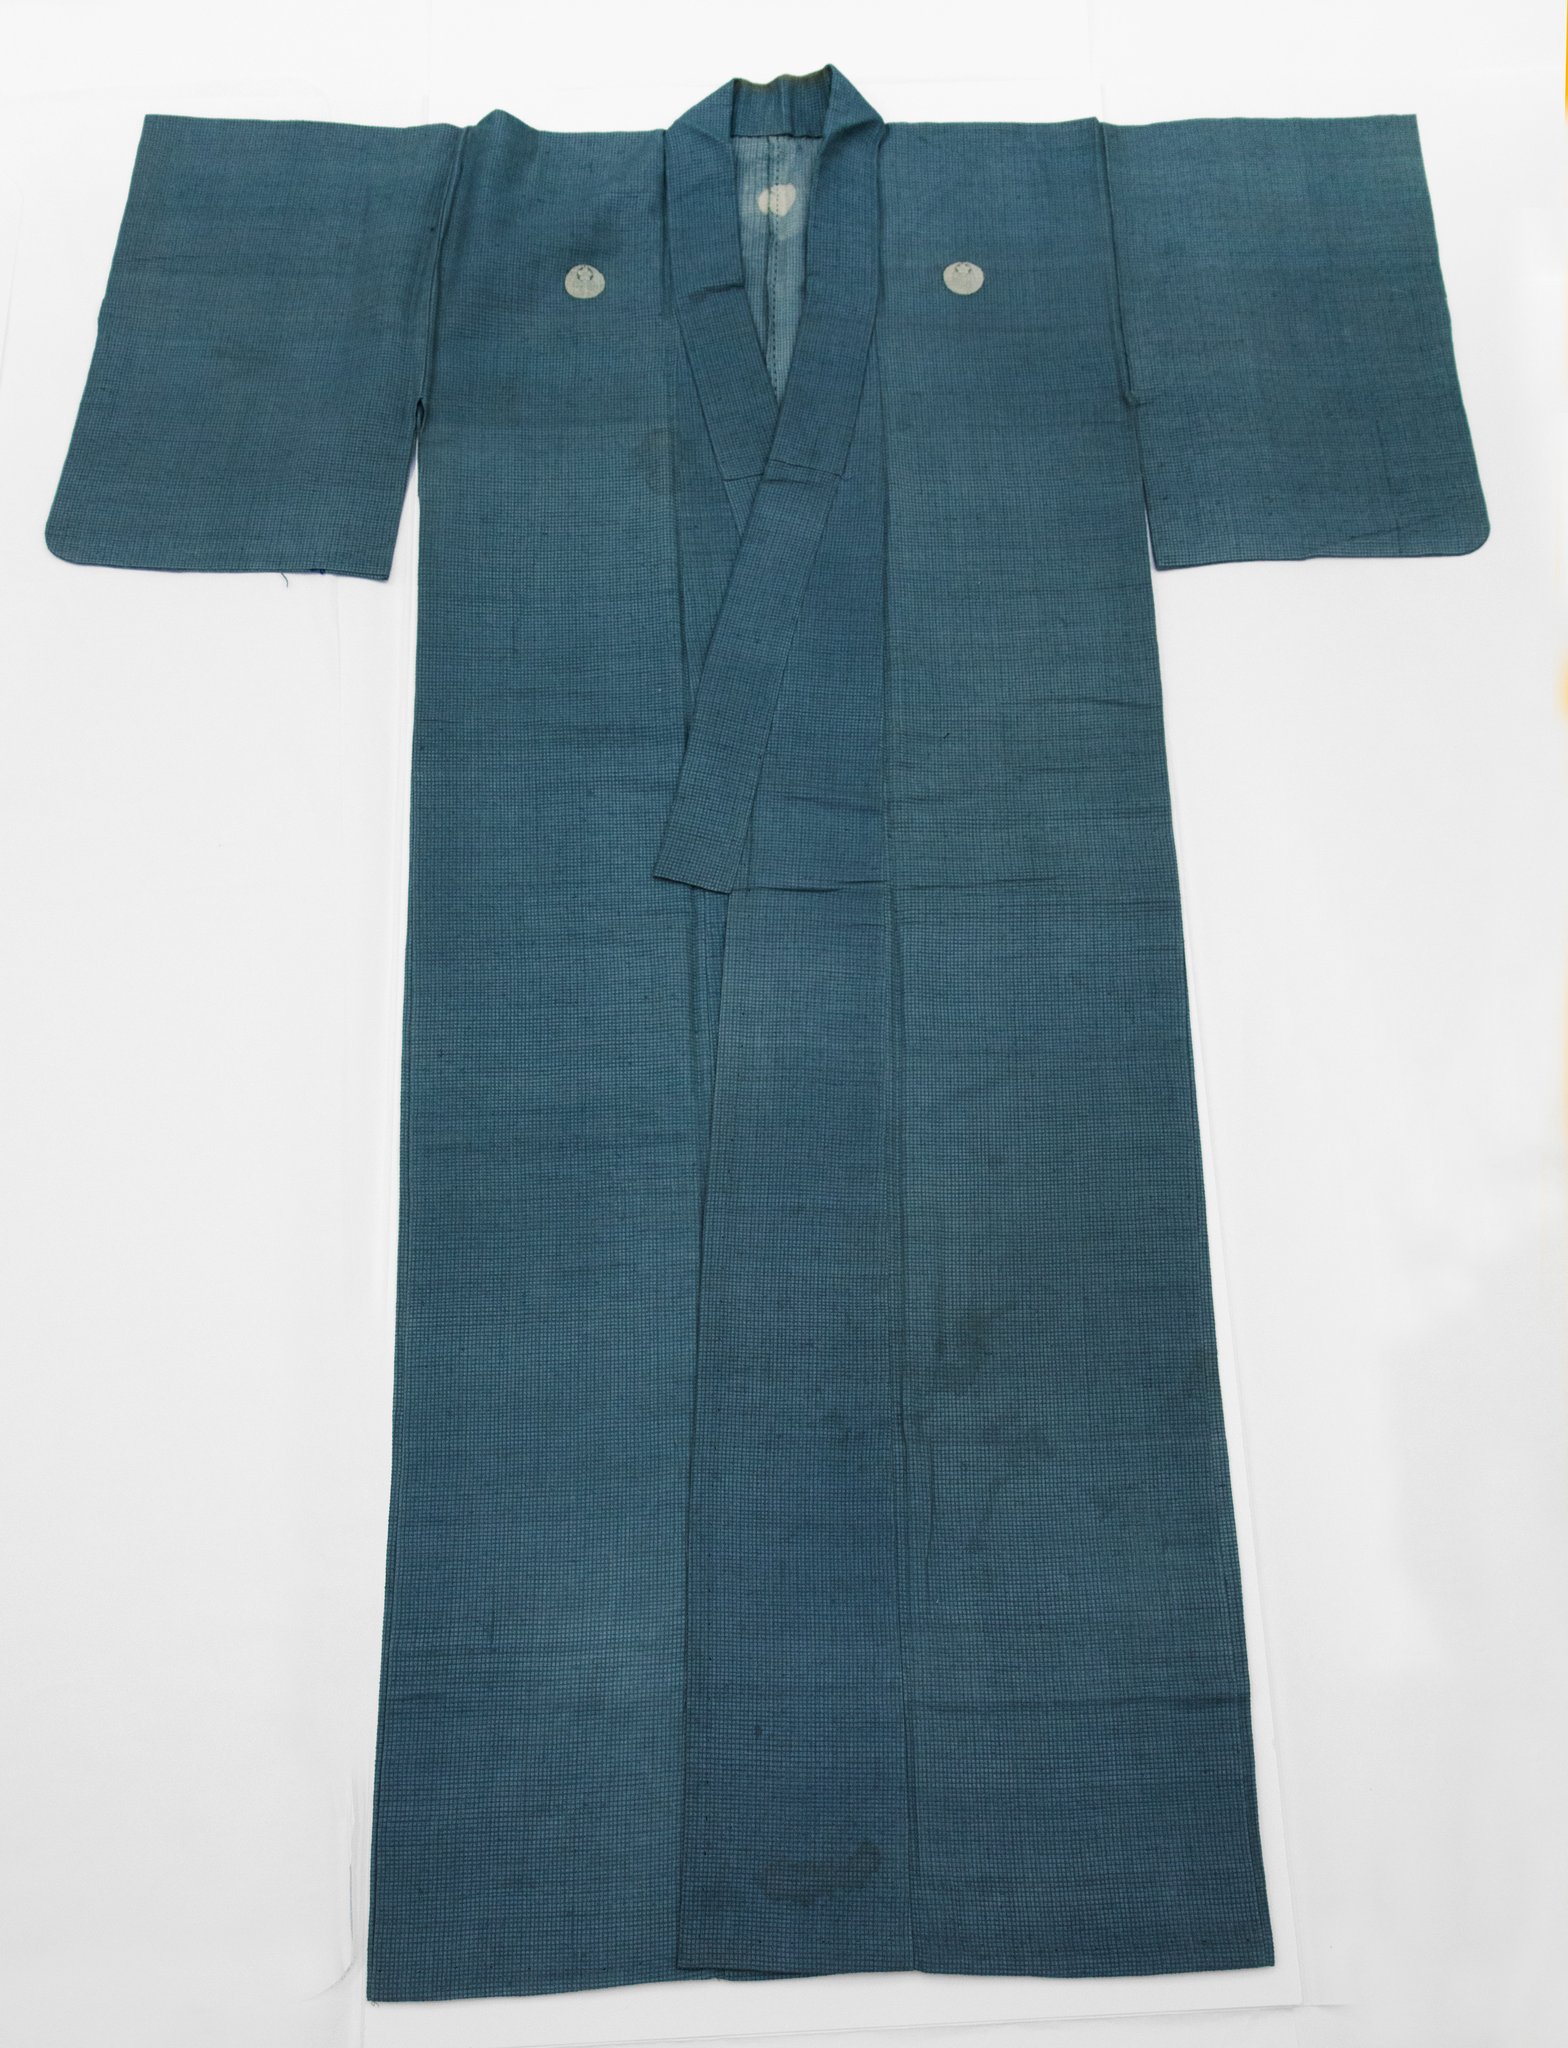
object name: kosode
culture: japanese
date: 1615-1868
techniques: dyeing, resist